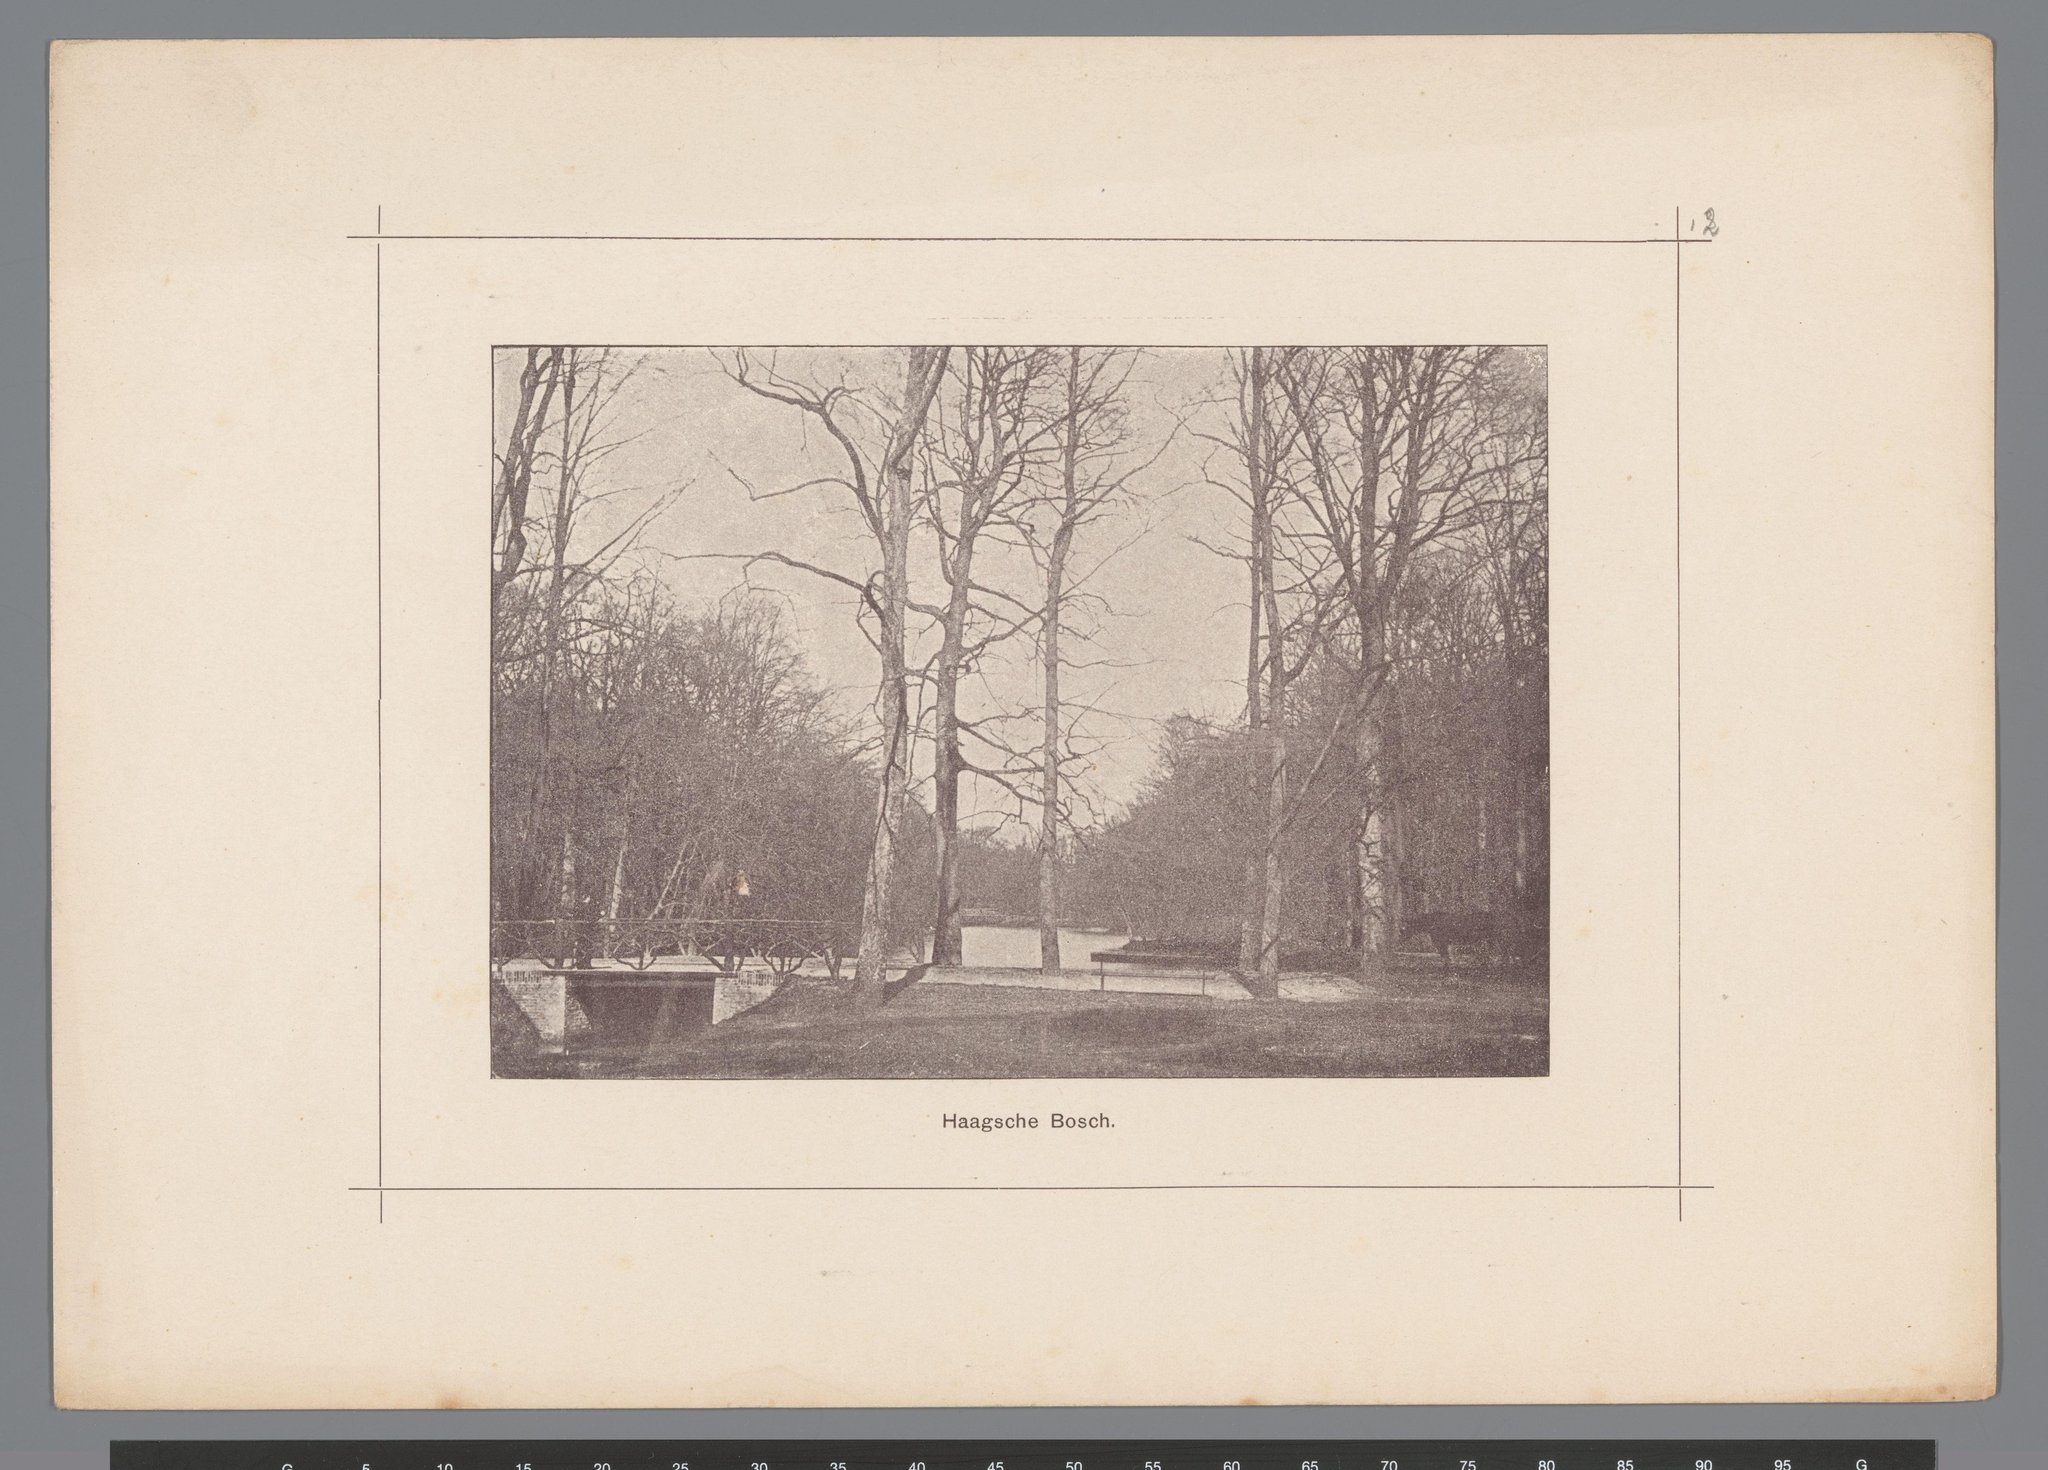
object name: photomechanical print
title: Haagsche Bosch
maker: Anonymous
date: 1880-1925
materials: paper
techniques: autotype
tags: forest, wood, bridge, the hague